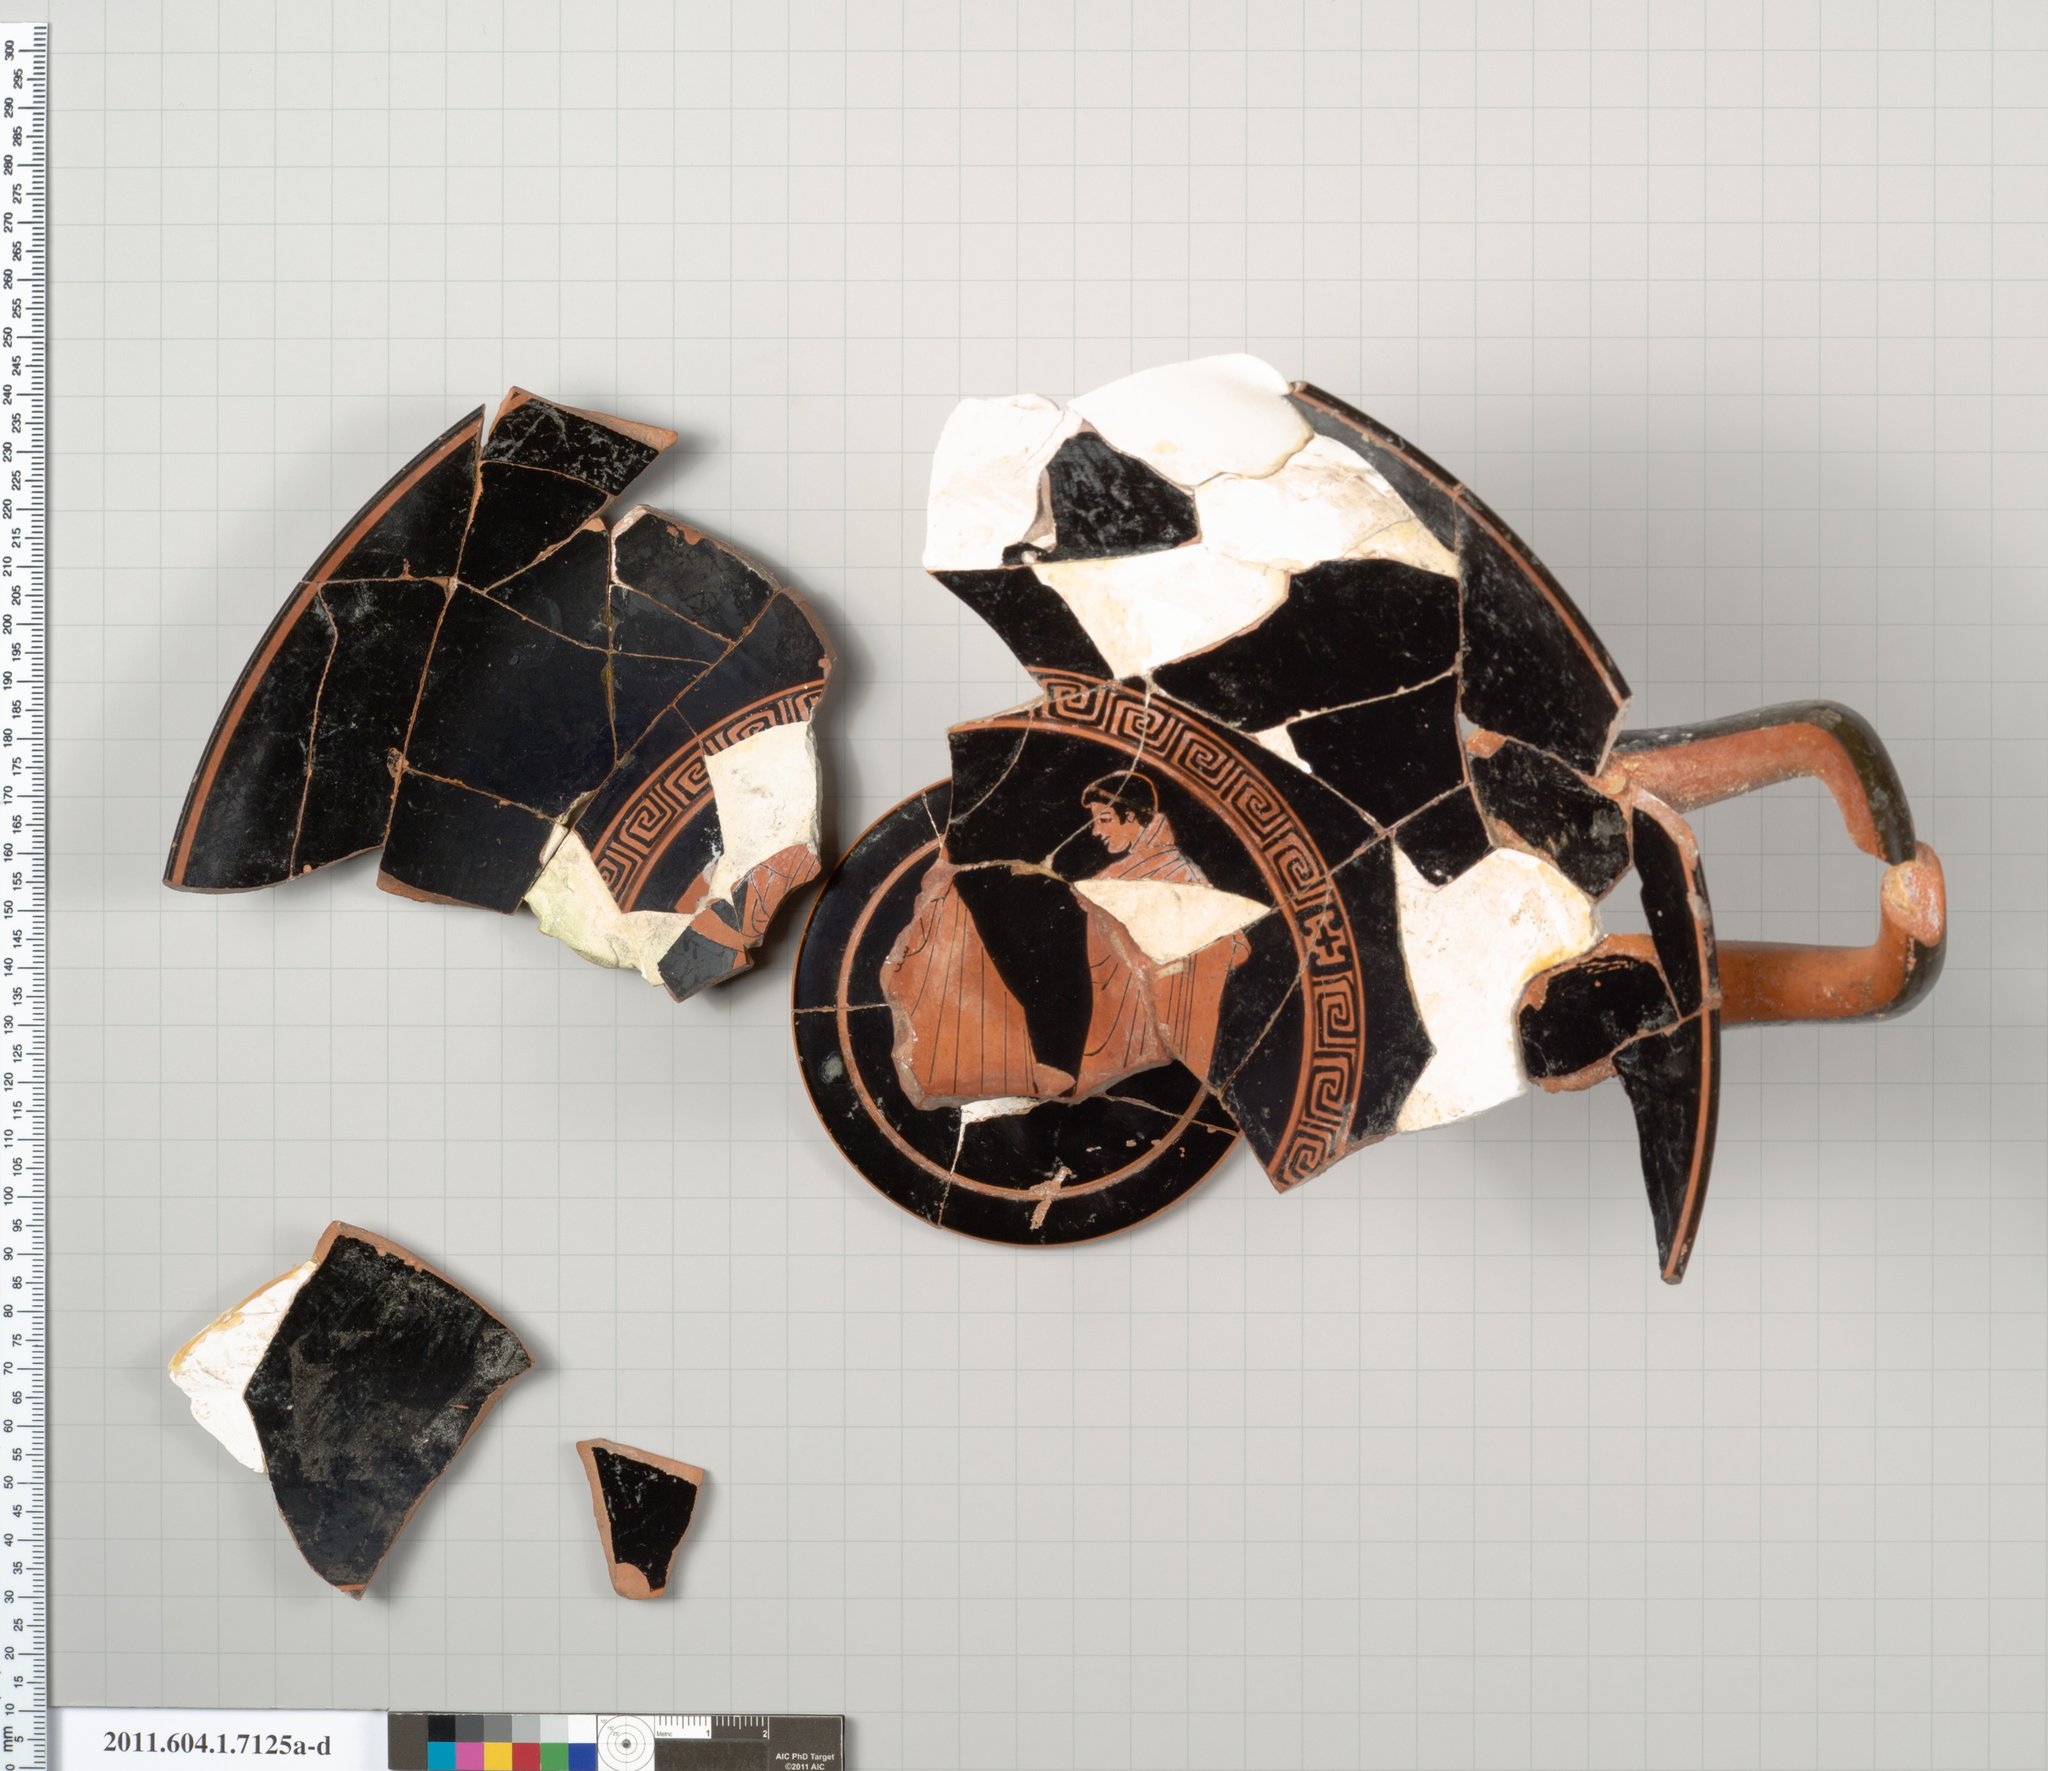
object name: kylix fragment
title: Terracotta fragments of a kylix (drinking cup)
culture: greek, attic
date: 475-451 BCE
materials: terracotta